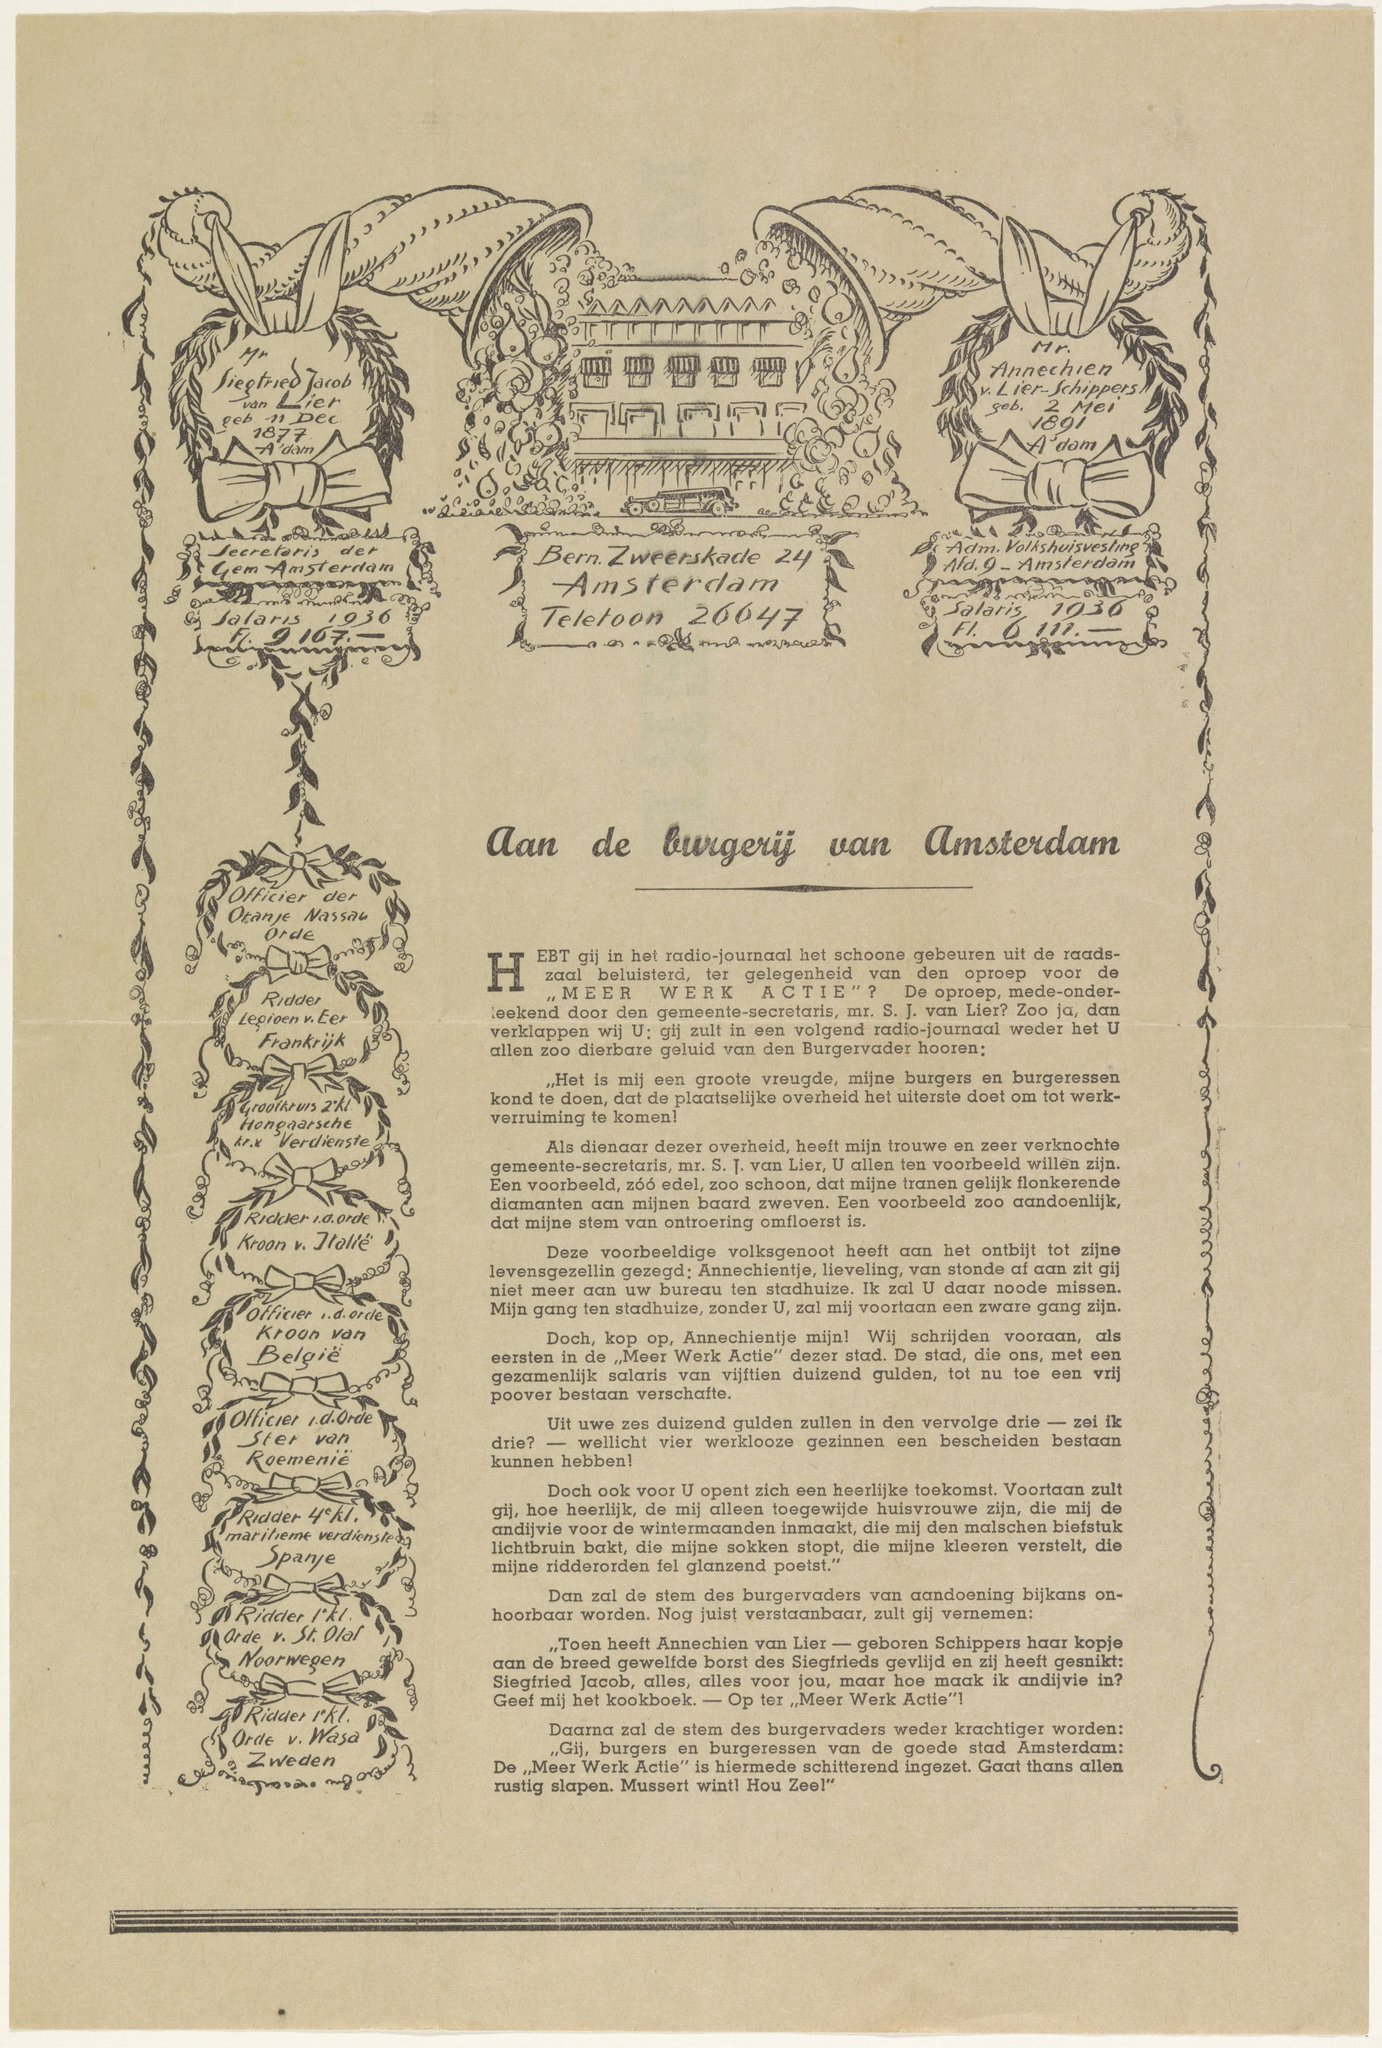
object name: print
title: NSB pamflet gericht tegen de Amsterdamse gemeentesecretaris S.J. van Lier en zijn vrouw, ca. 1936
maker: Anonymous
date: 1936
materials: paper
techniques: lithograph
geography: netherlands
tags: the hague, politician, anton adriaan mussert, amsterdam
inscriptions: collector's mark: Lugt 2228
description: Pamflet van de NSB naar aanleiding van de hoge salarissen van Siegfried.J. van Lier, de joodse secretaris van de gemeente Amsterdam, en zijn vrouw Annechien Van Lier-Schippers en de heersende werkloosheid in de stad Amsterdam, ca. 1936. Bovenaan het huis van het echtpaar Van Lier aan de Bernard Zweerskade overgoten door fruit uit twee hoornen van overvloed. Met tekst beginnend met het opschrift 'Aan de burgerij van Amsterdam', en eindigend met 'Mussert wint! Hou Zee!' Op de achterzijde bedrukt met het opschrift 'Meer Werk'.